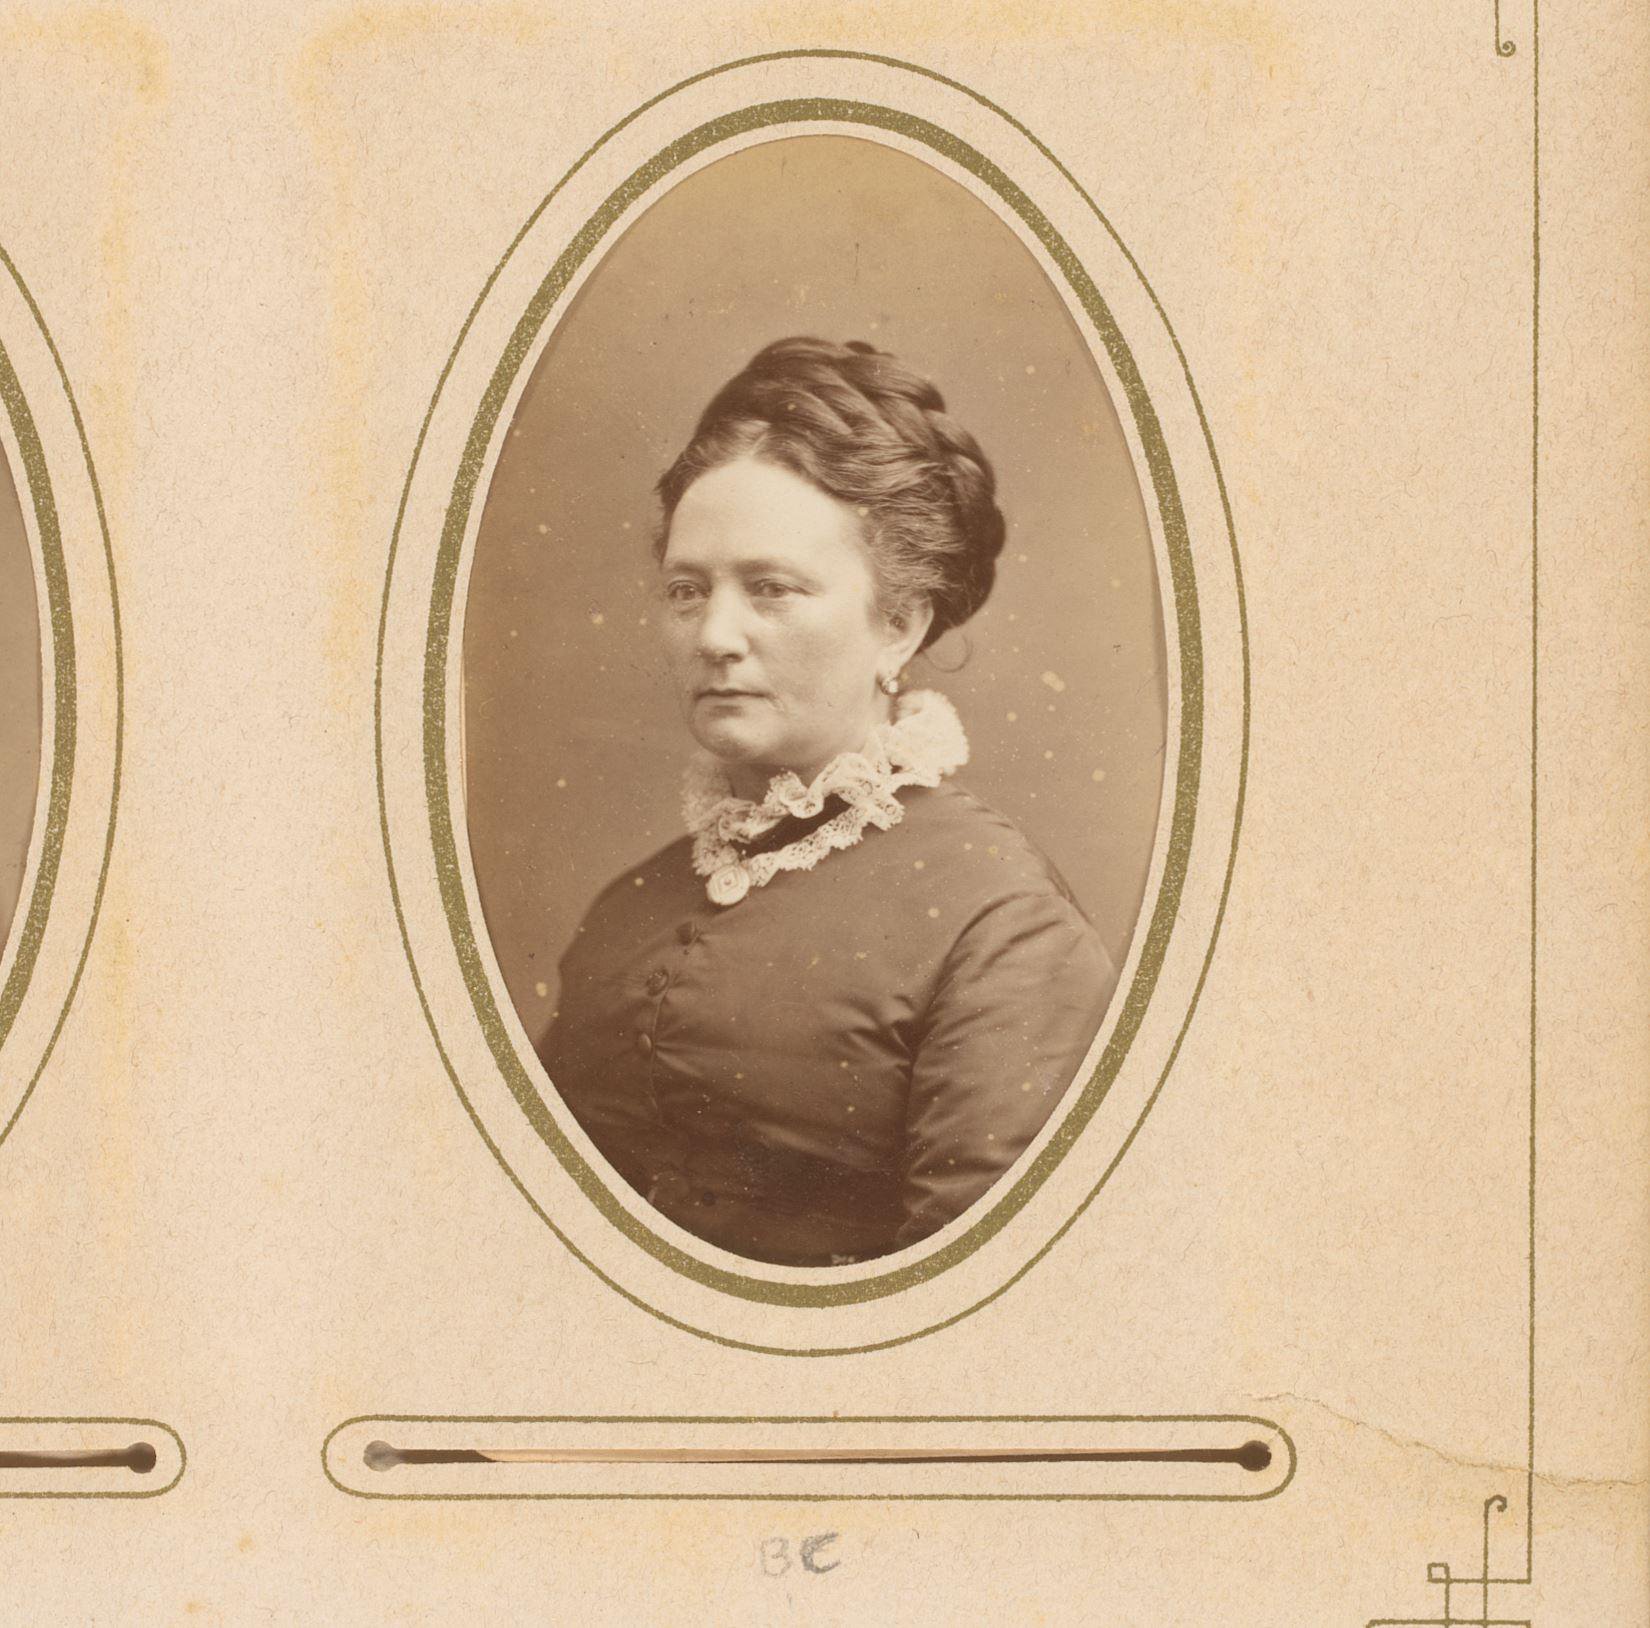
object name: photograph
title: Portret van een vrouw met halsketting met medaillon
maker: albert greiner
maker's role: fotograaf, fotostudio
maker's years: 1833-1890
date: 1861-1874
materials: cardboard, photographic support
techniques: albumen print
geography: assen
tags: historical persons - bb - woman, pendant, trinket, 'breloque'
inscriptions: inscription: ‘A. Greiner/ Photograf/ NIEUWENDIJK L. 87/ AMSTERDAM’